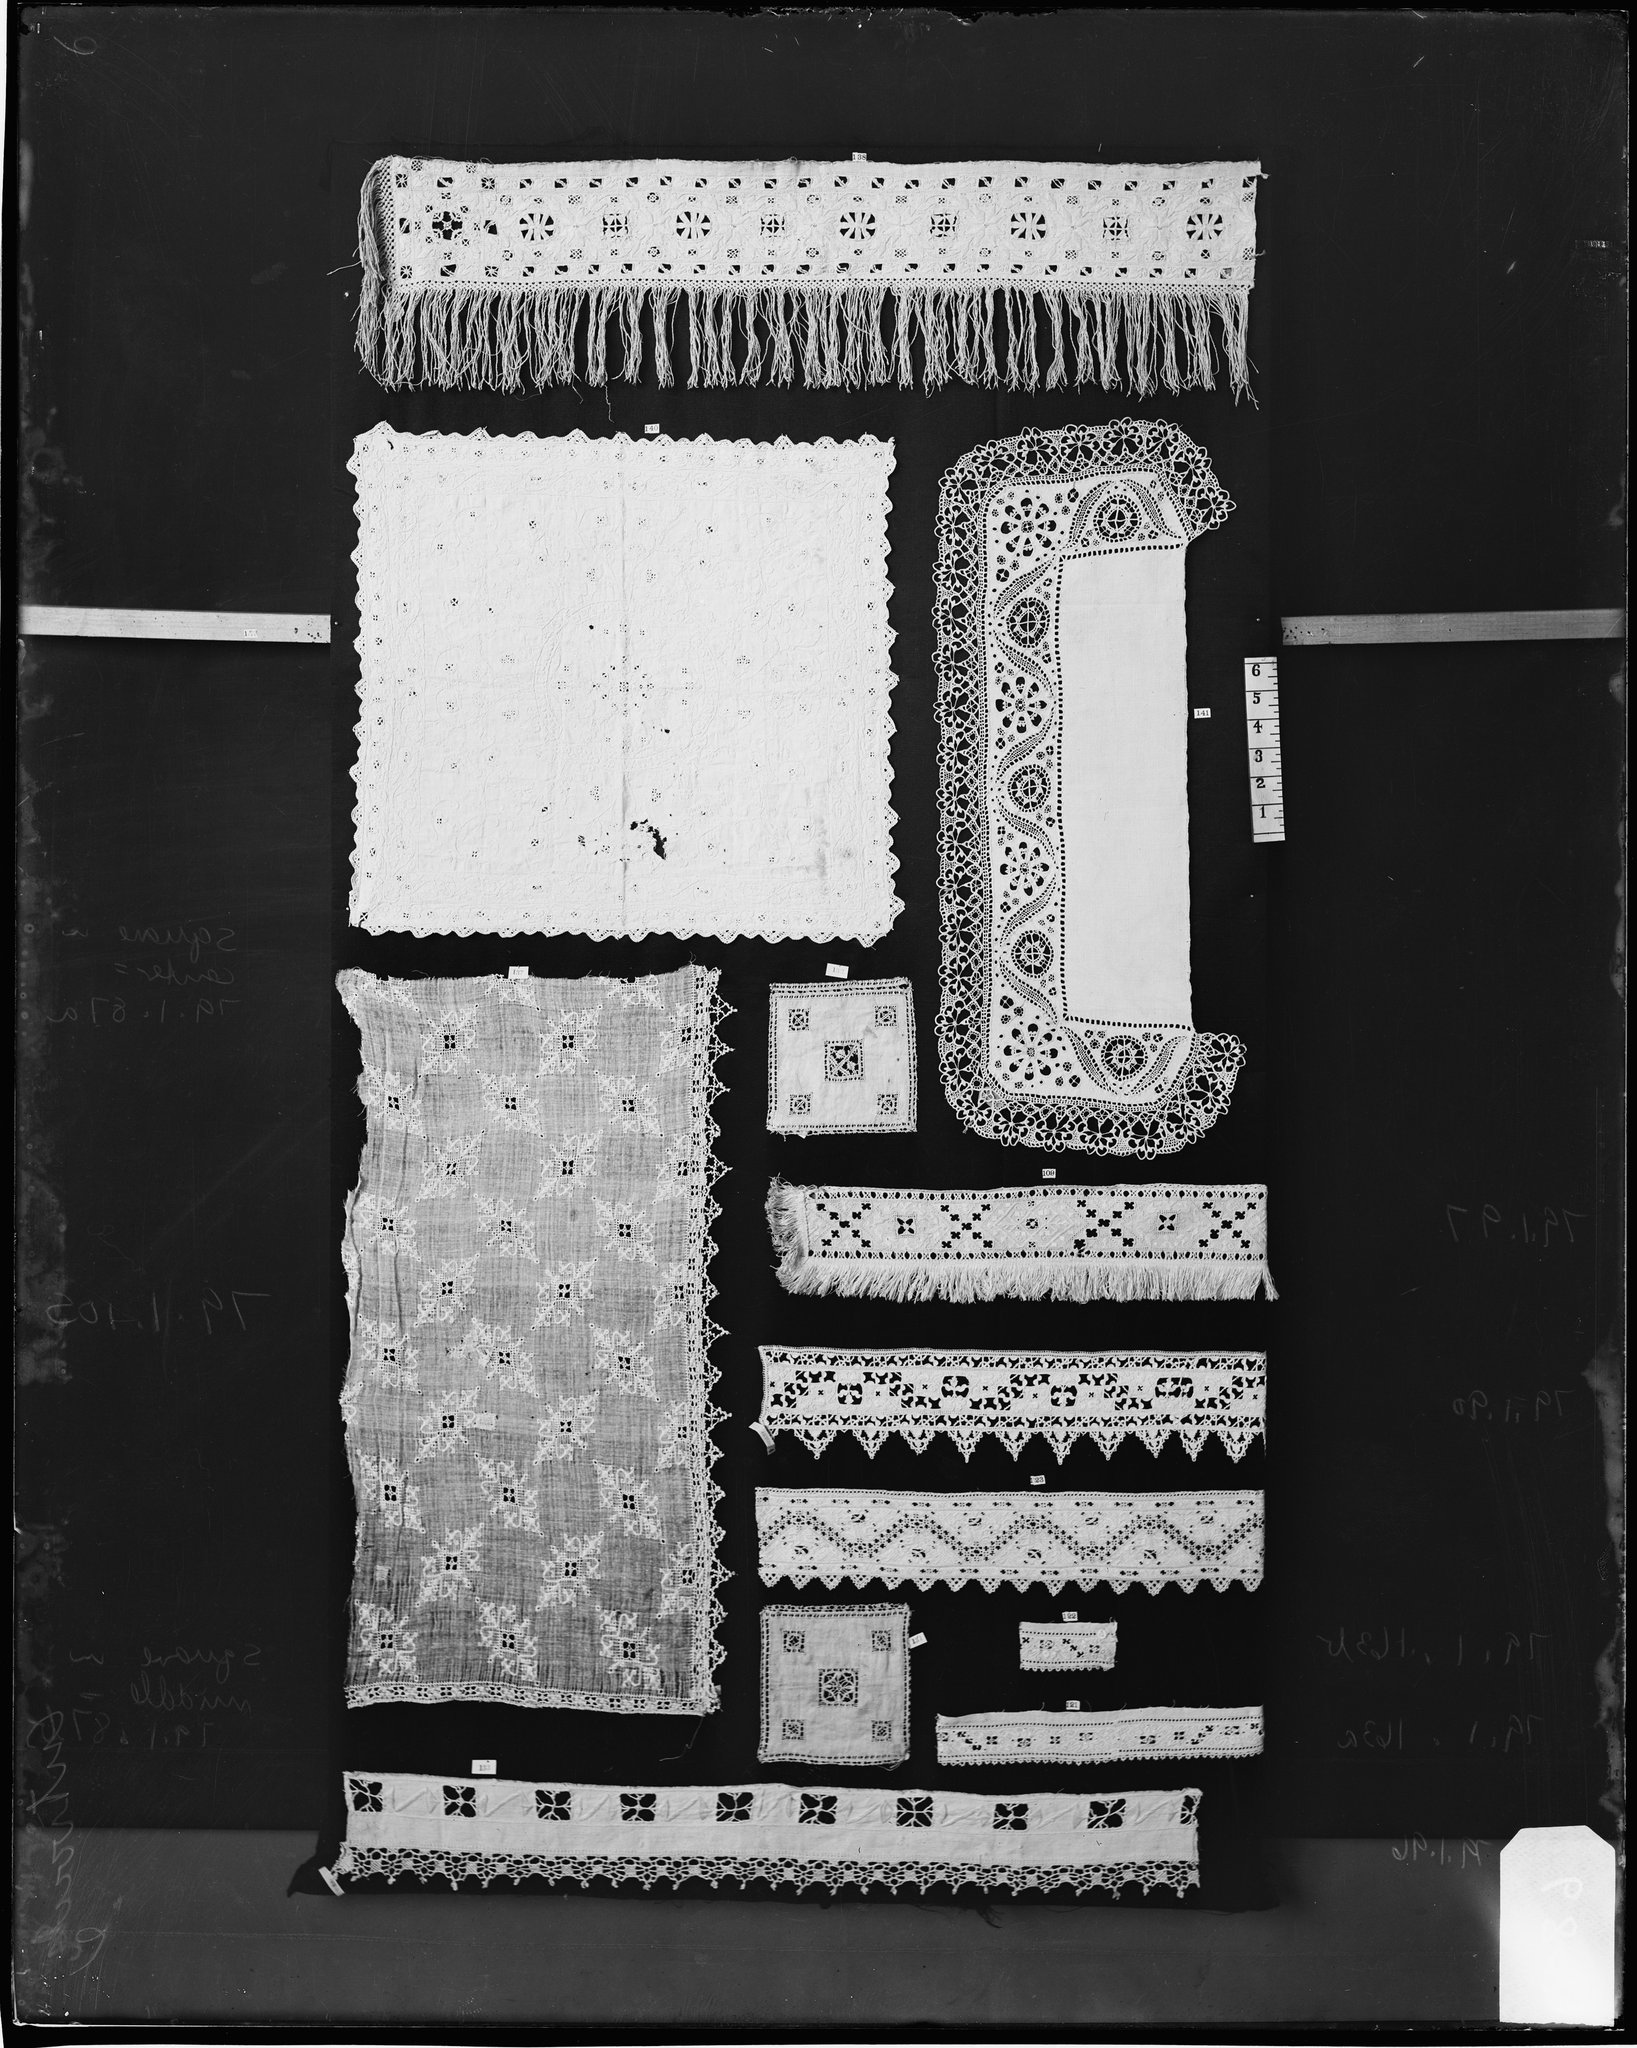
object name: strip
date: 1501-1600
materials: linen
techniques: embroidery